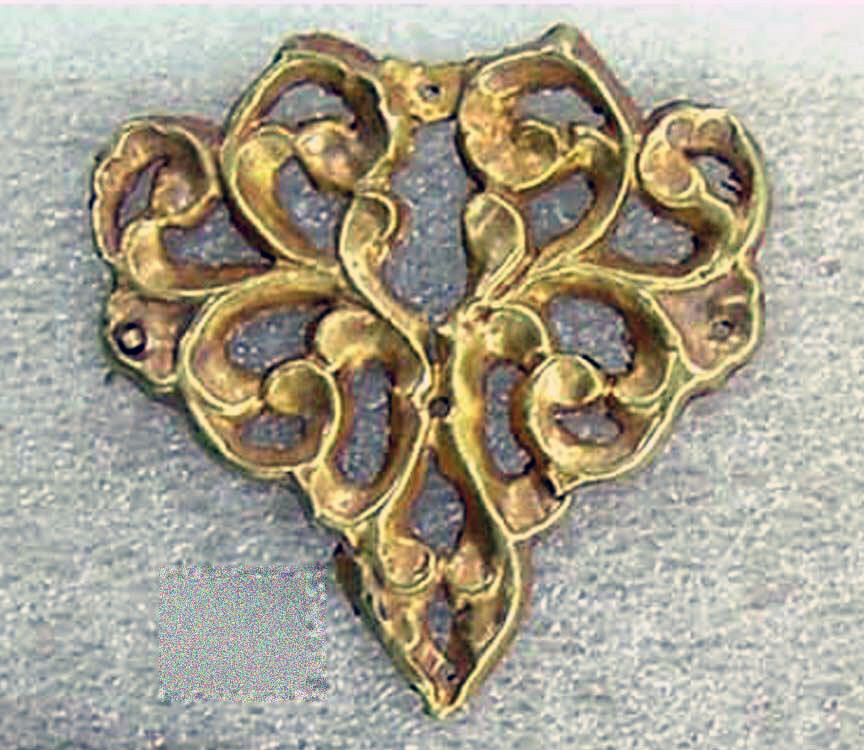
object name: plaque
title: Triangular Plaque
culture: northwest chinese or eastern central asian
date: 634-900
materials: gold